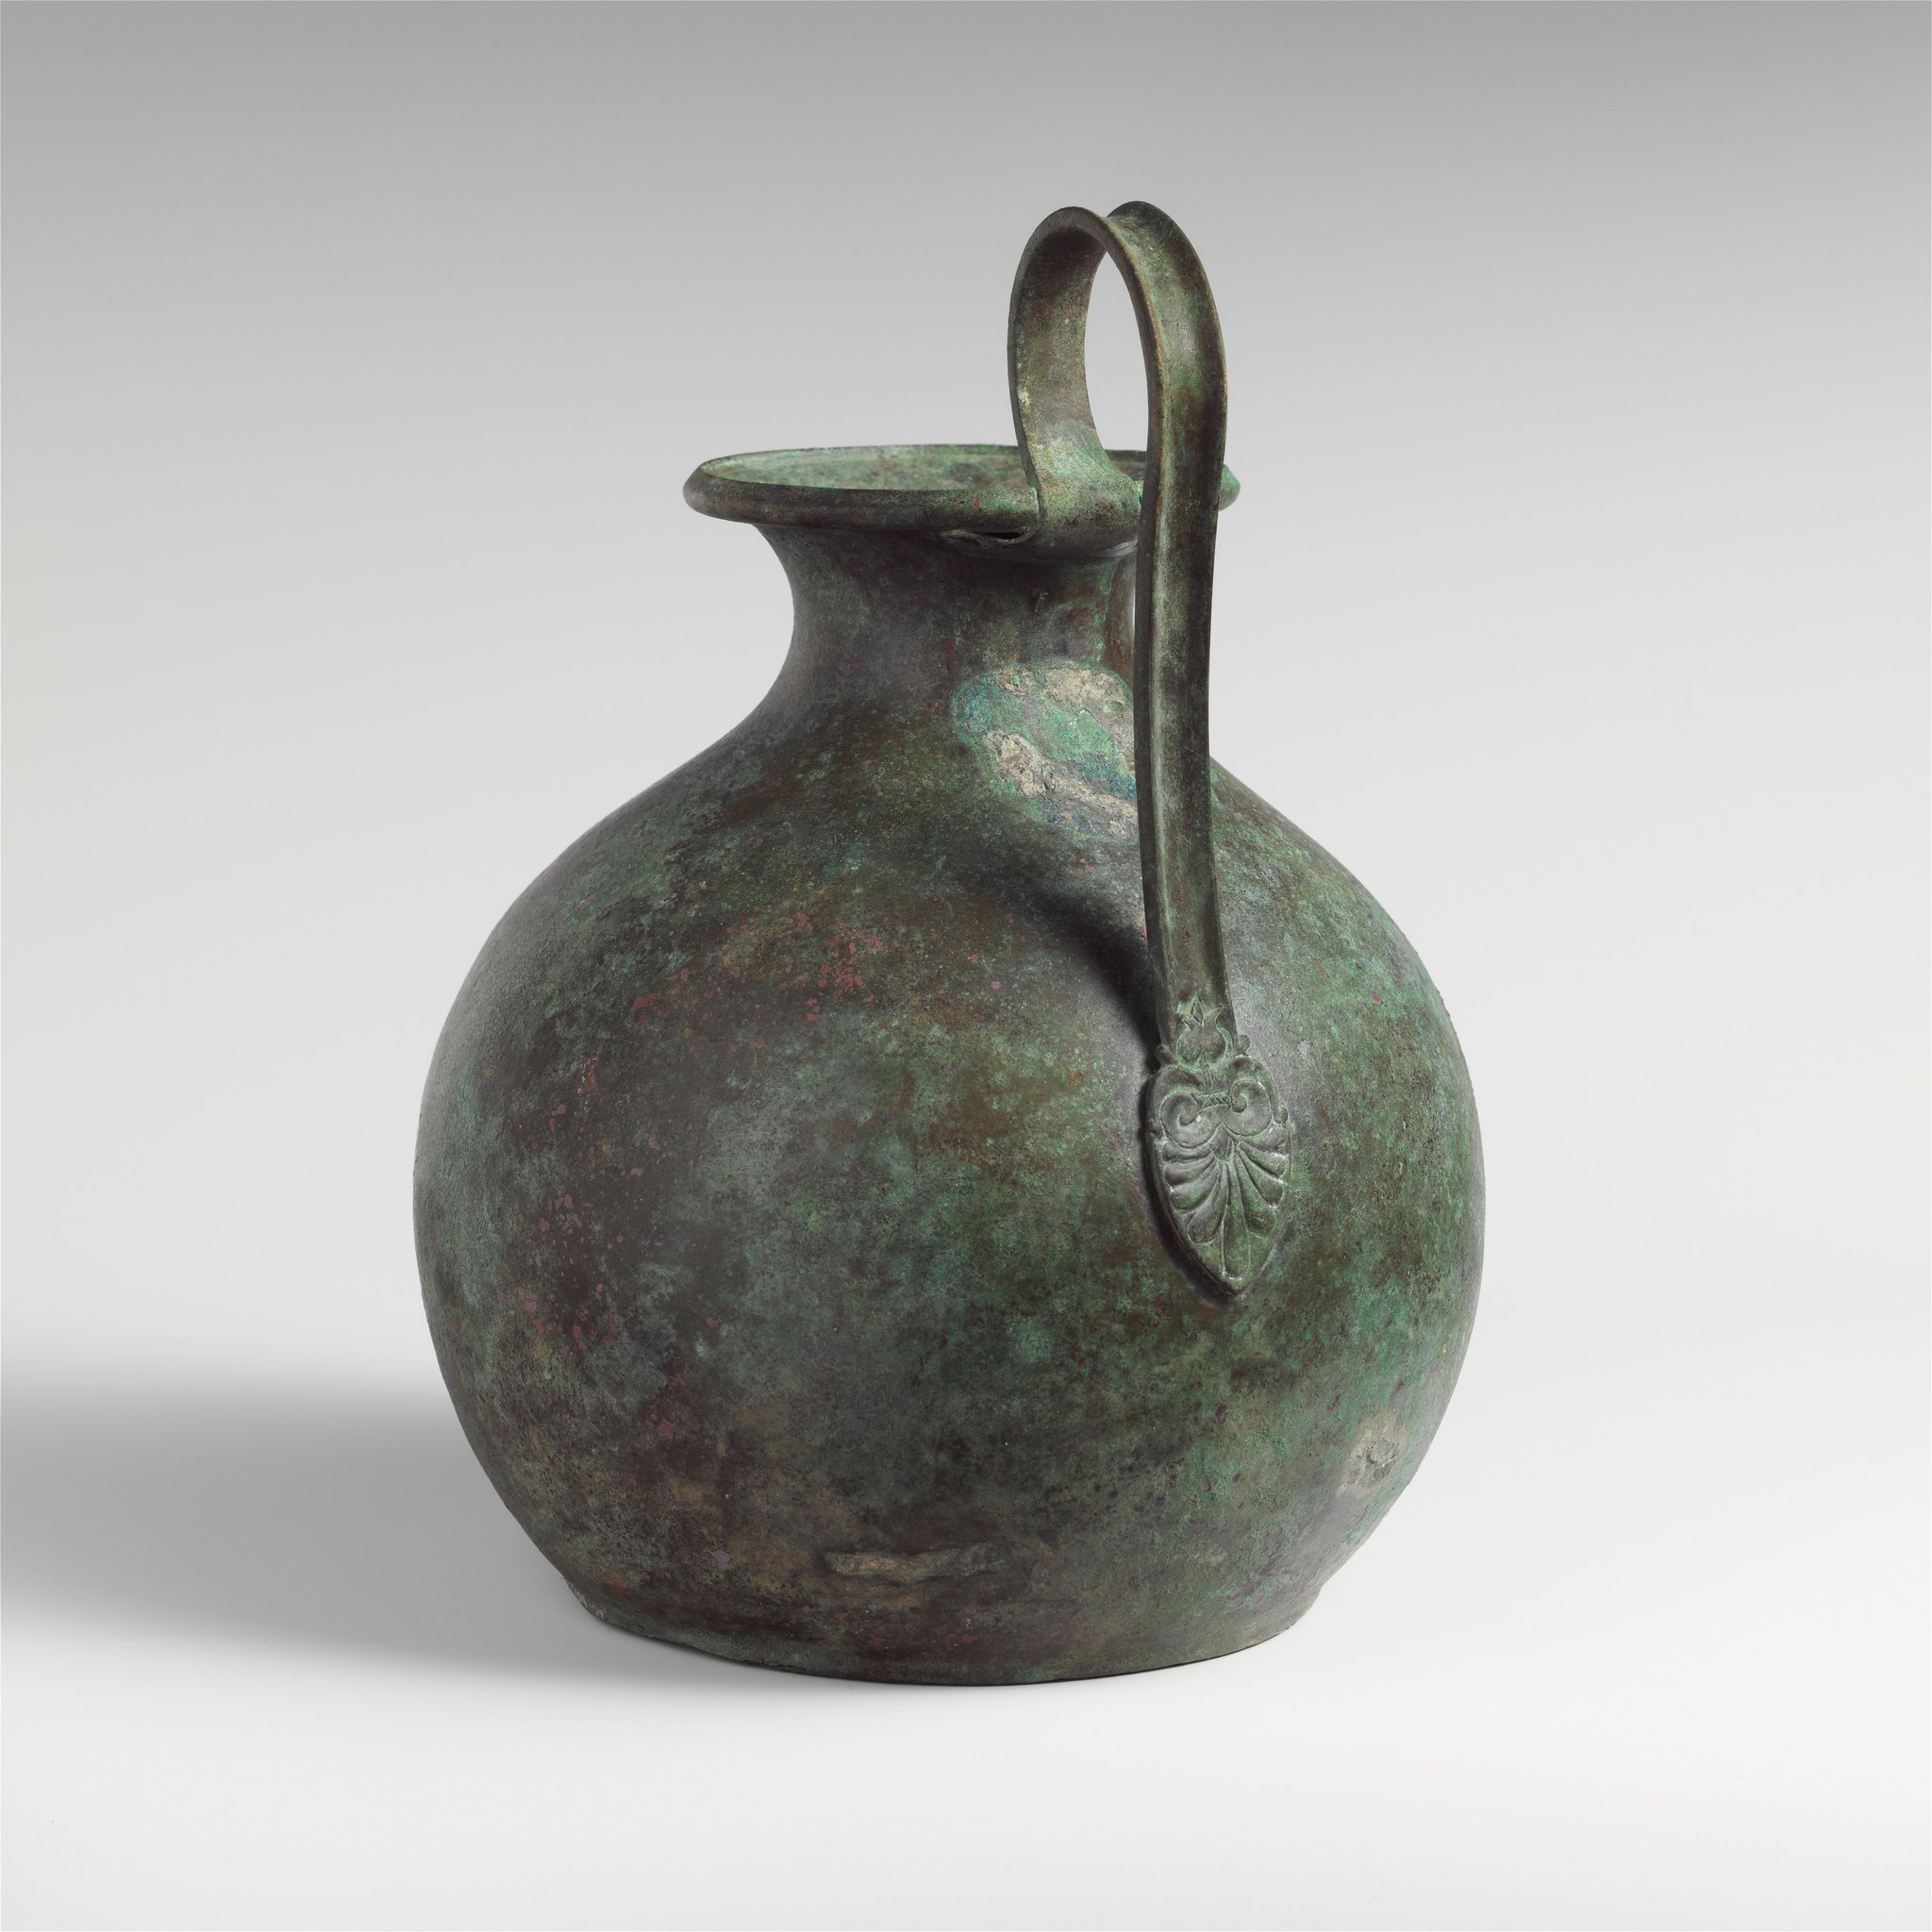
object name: oinochoe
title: Bronze oinochoe (jug)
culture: east greek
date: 534-501 BCE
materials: bronze